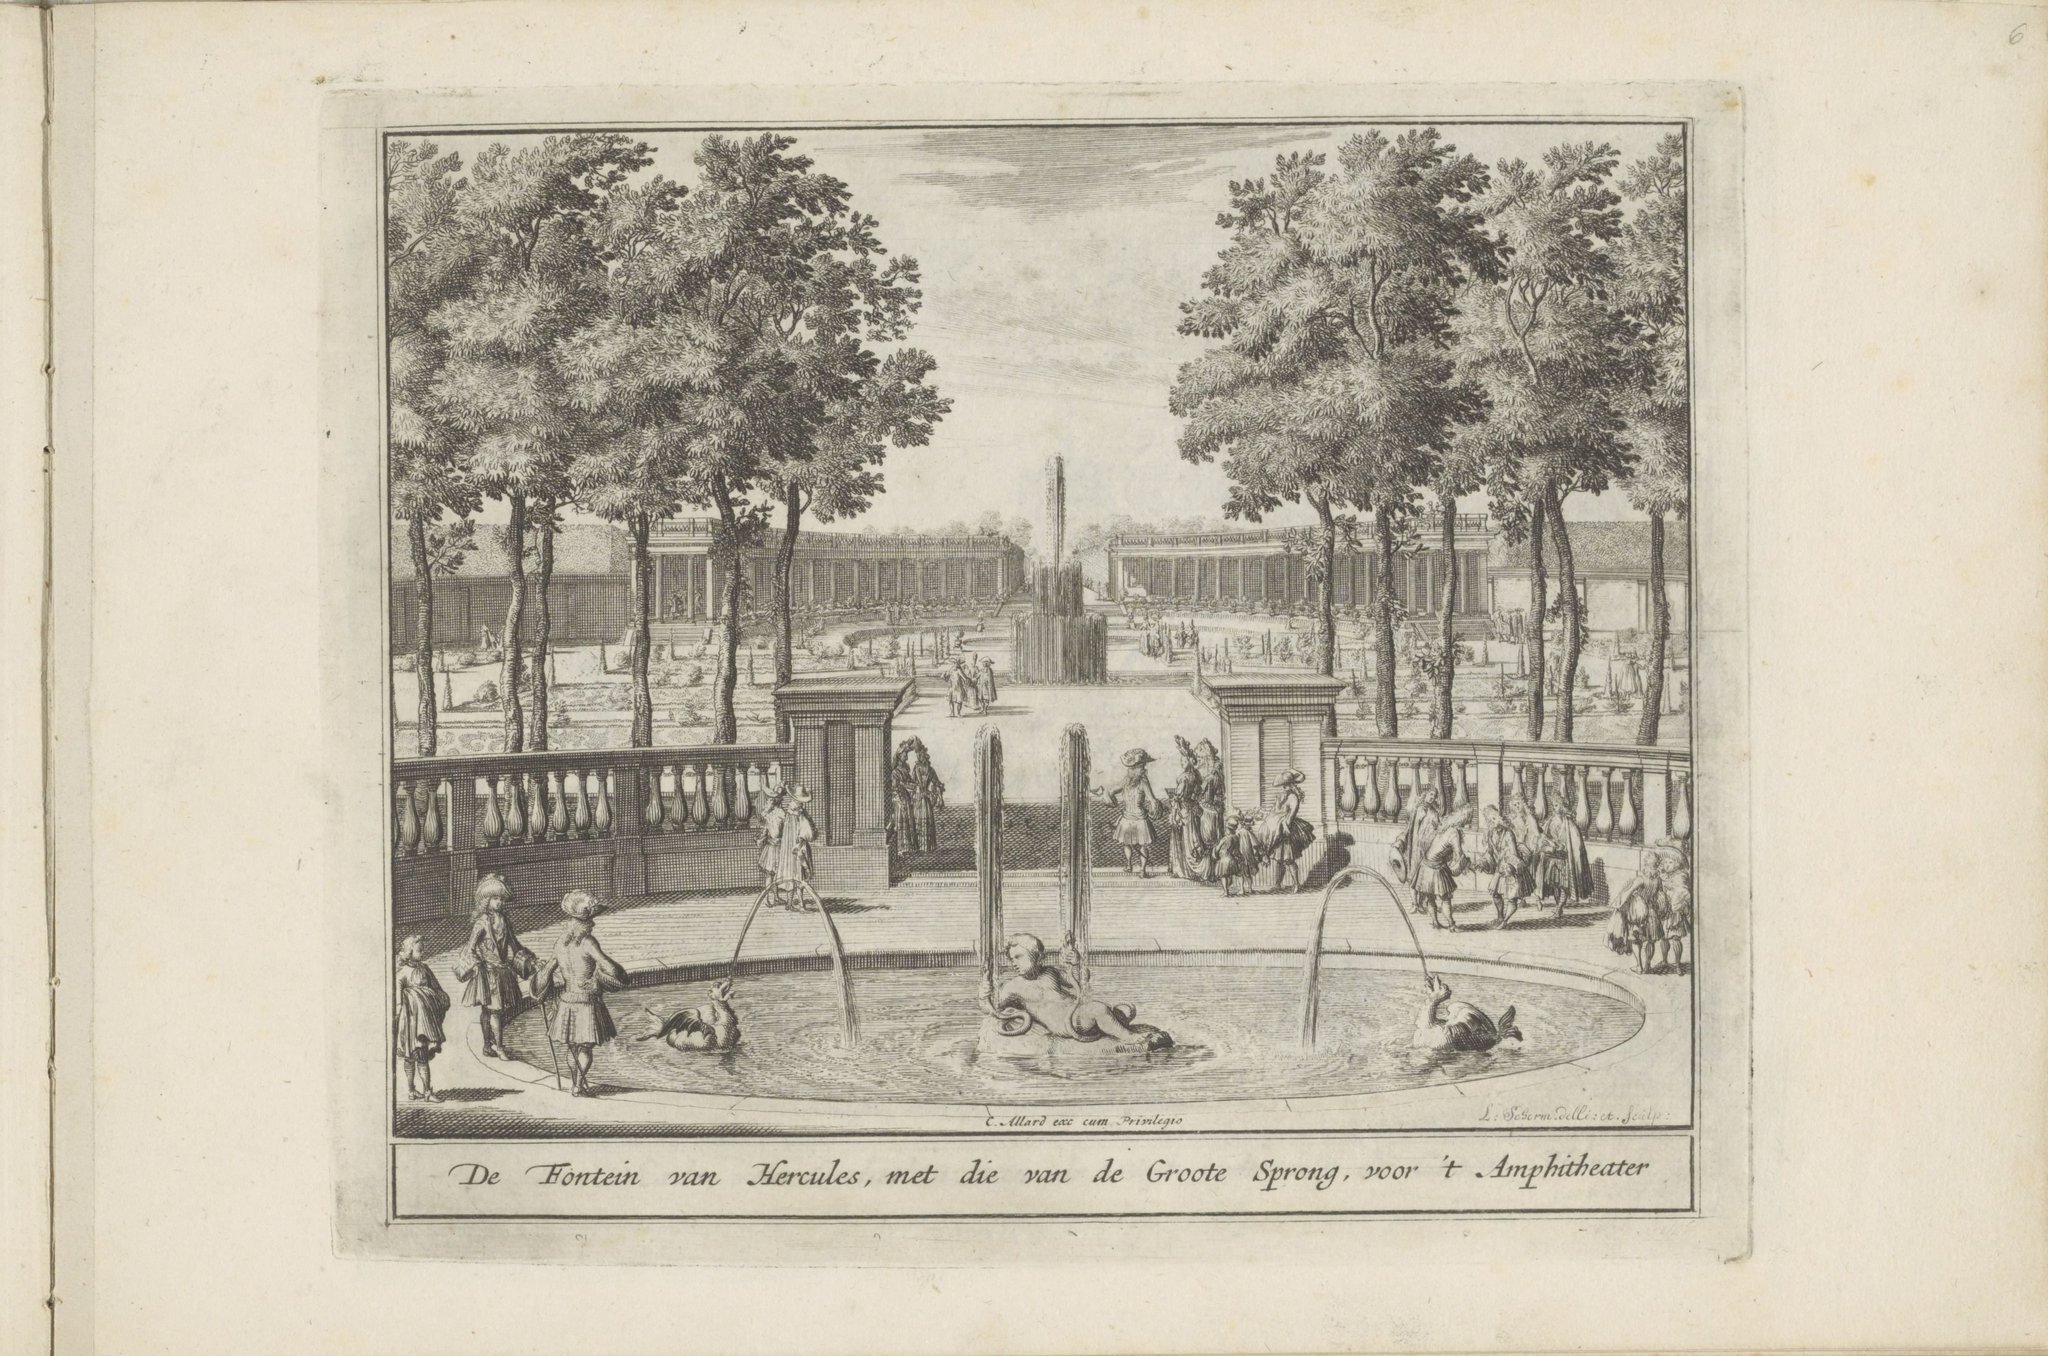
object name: album leaf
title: De Fontein van Hercules, met die van de Groote Sprong, voor 't Amphitheater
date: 1689-1701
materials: paper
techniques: etching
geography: amsterdam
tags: french or architectonic garden; formal garden, ornamental fountain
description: Gezicht op de fontein van Hercules met daarachter de grote fontein (Koningssprong) en het amfitheater. Prent maakt deel uit van een album.